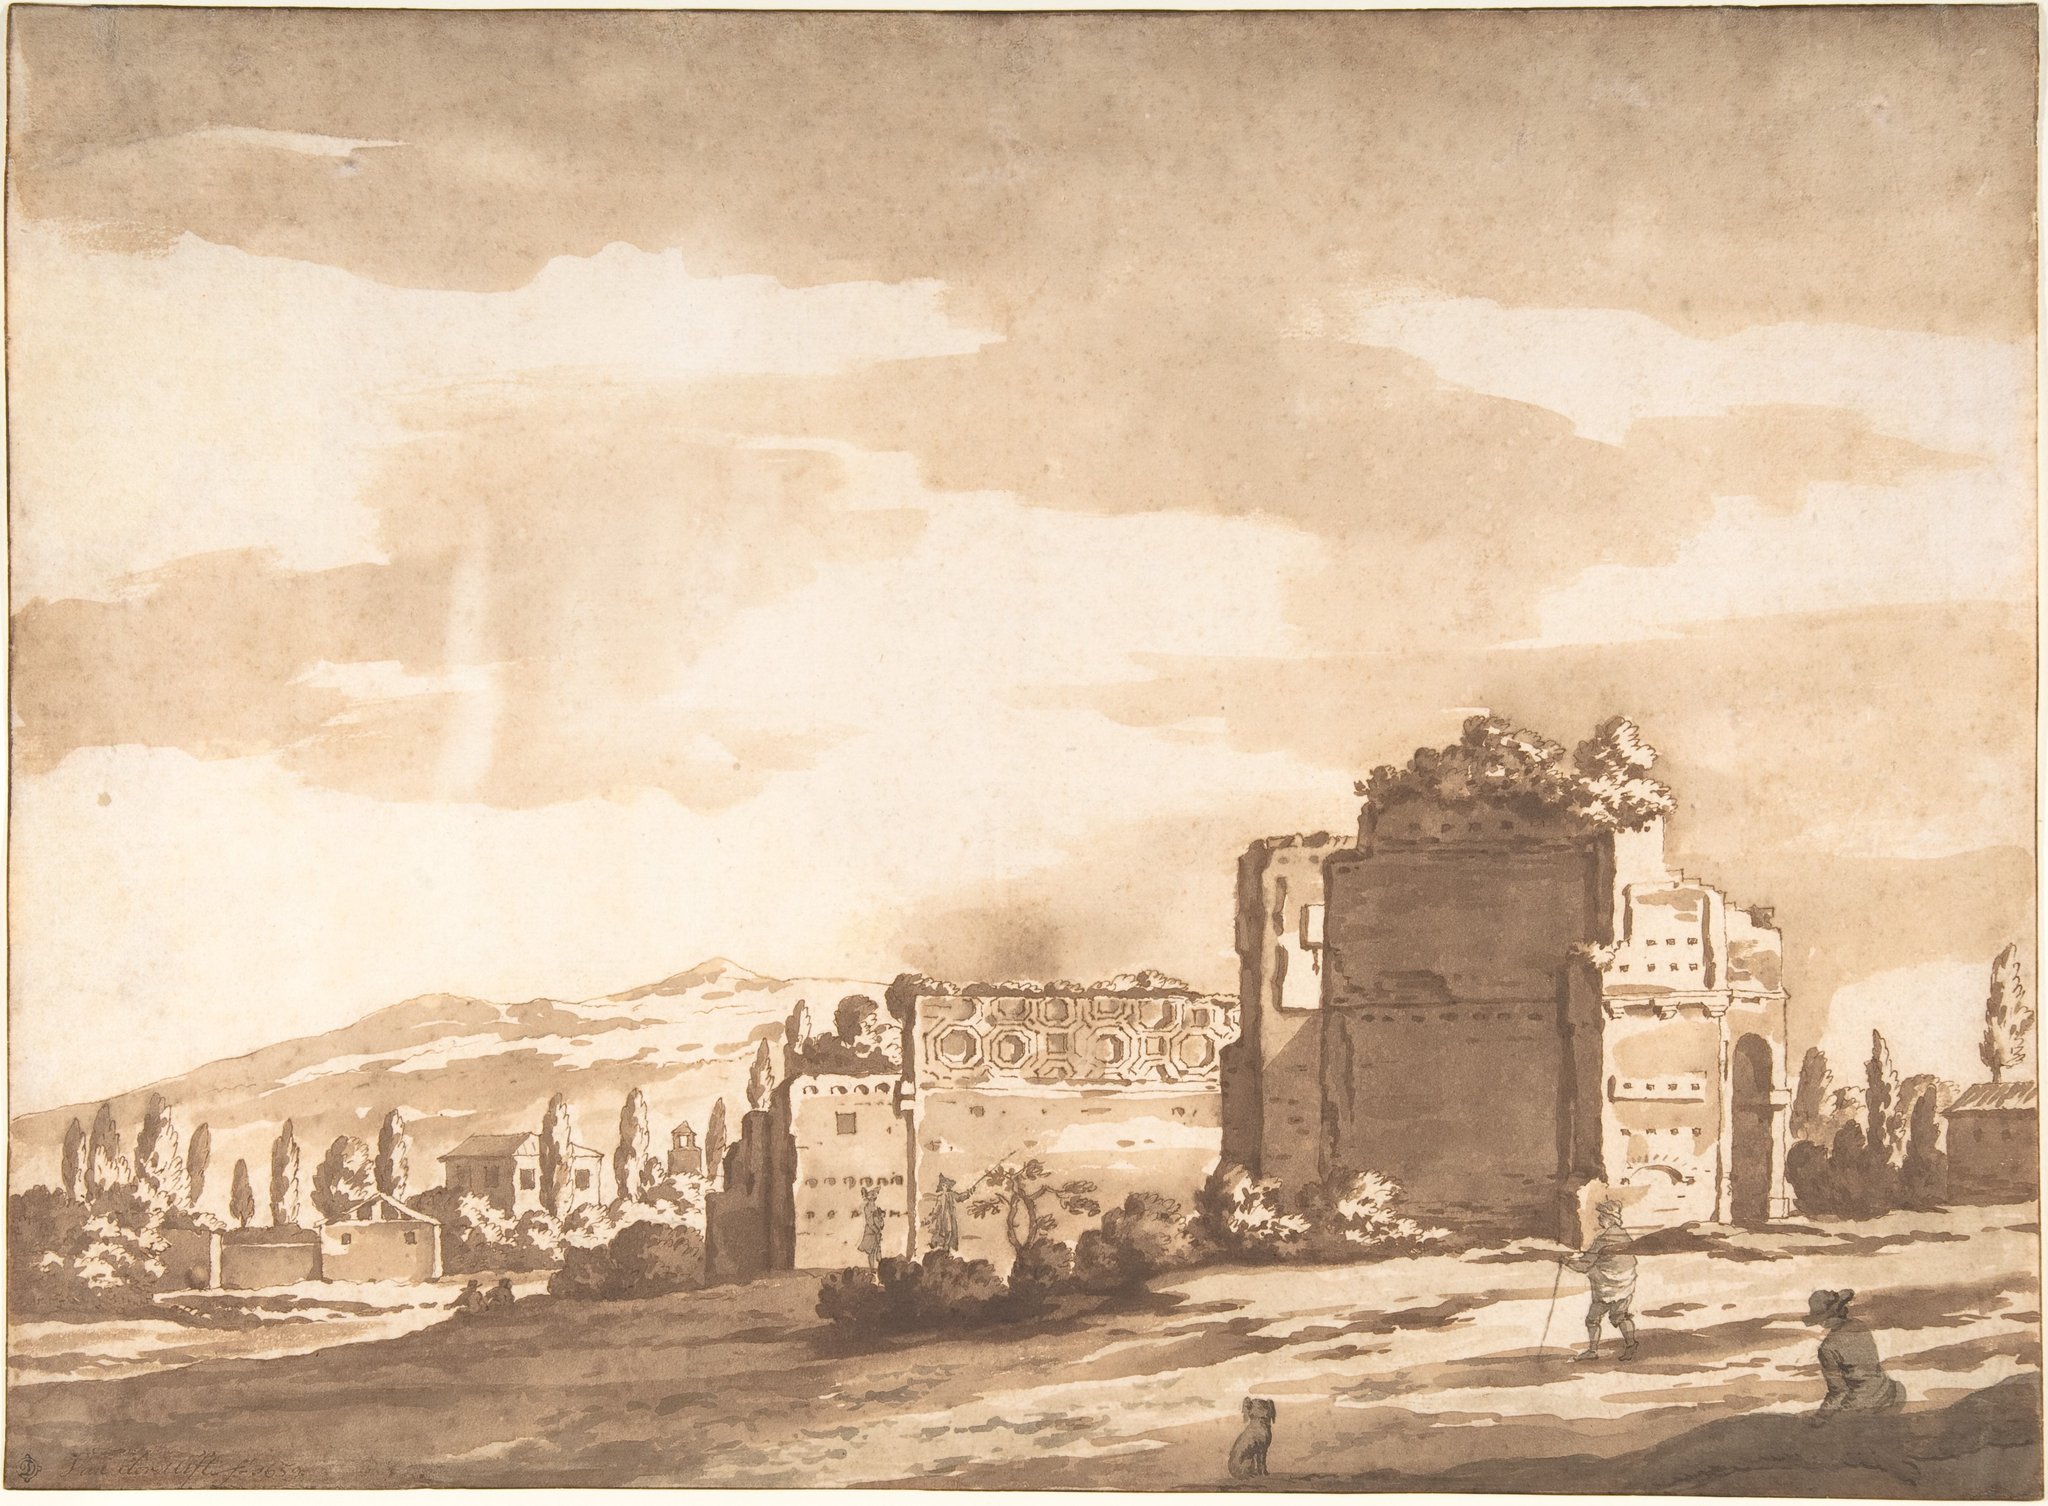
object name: drawing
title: Italian Landscape, perhaps the Monte Mario, Rome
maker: jacob van der ulft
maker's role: artist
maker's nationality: dutch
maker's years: 1627-1689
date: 1659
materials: ink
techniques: brush, pen, wash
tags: ruins,hills,landscapes,rome